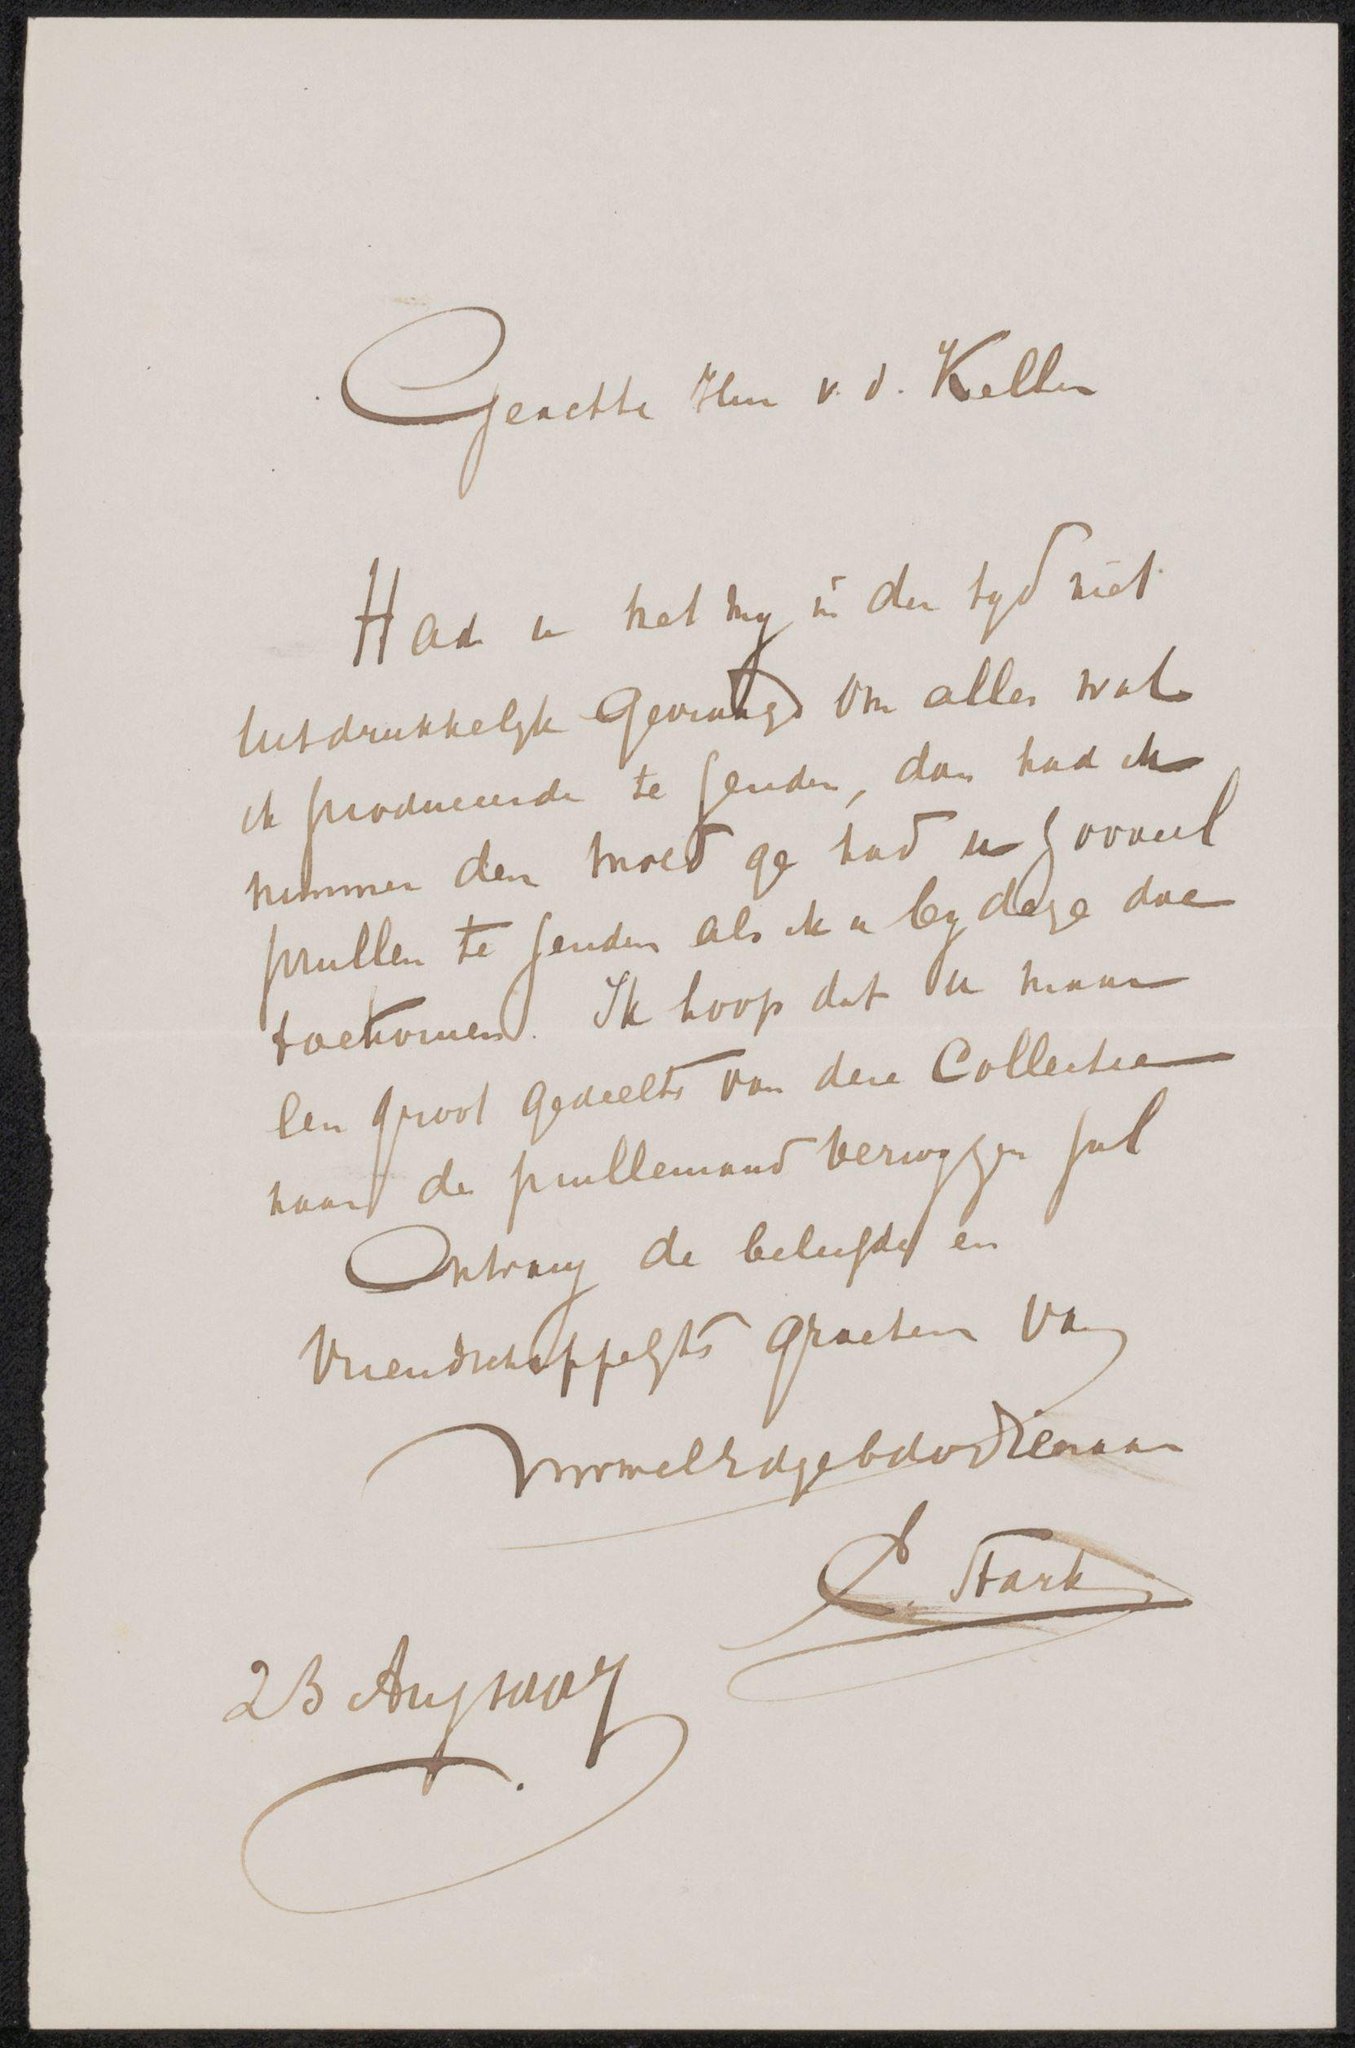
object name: letter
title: Brief aan Johan Philip van der Kellen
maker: elias stark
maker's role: draughtsman, print maker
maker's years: 1849-1933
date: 1887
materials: ink, paper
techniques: pen, writing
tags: utrecht, johan philip van der kellen